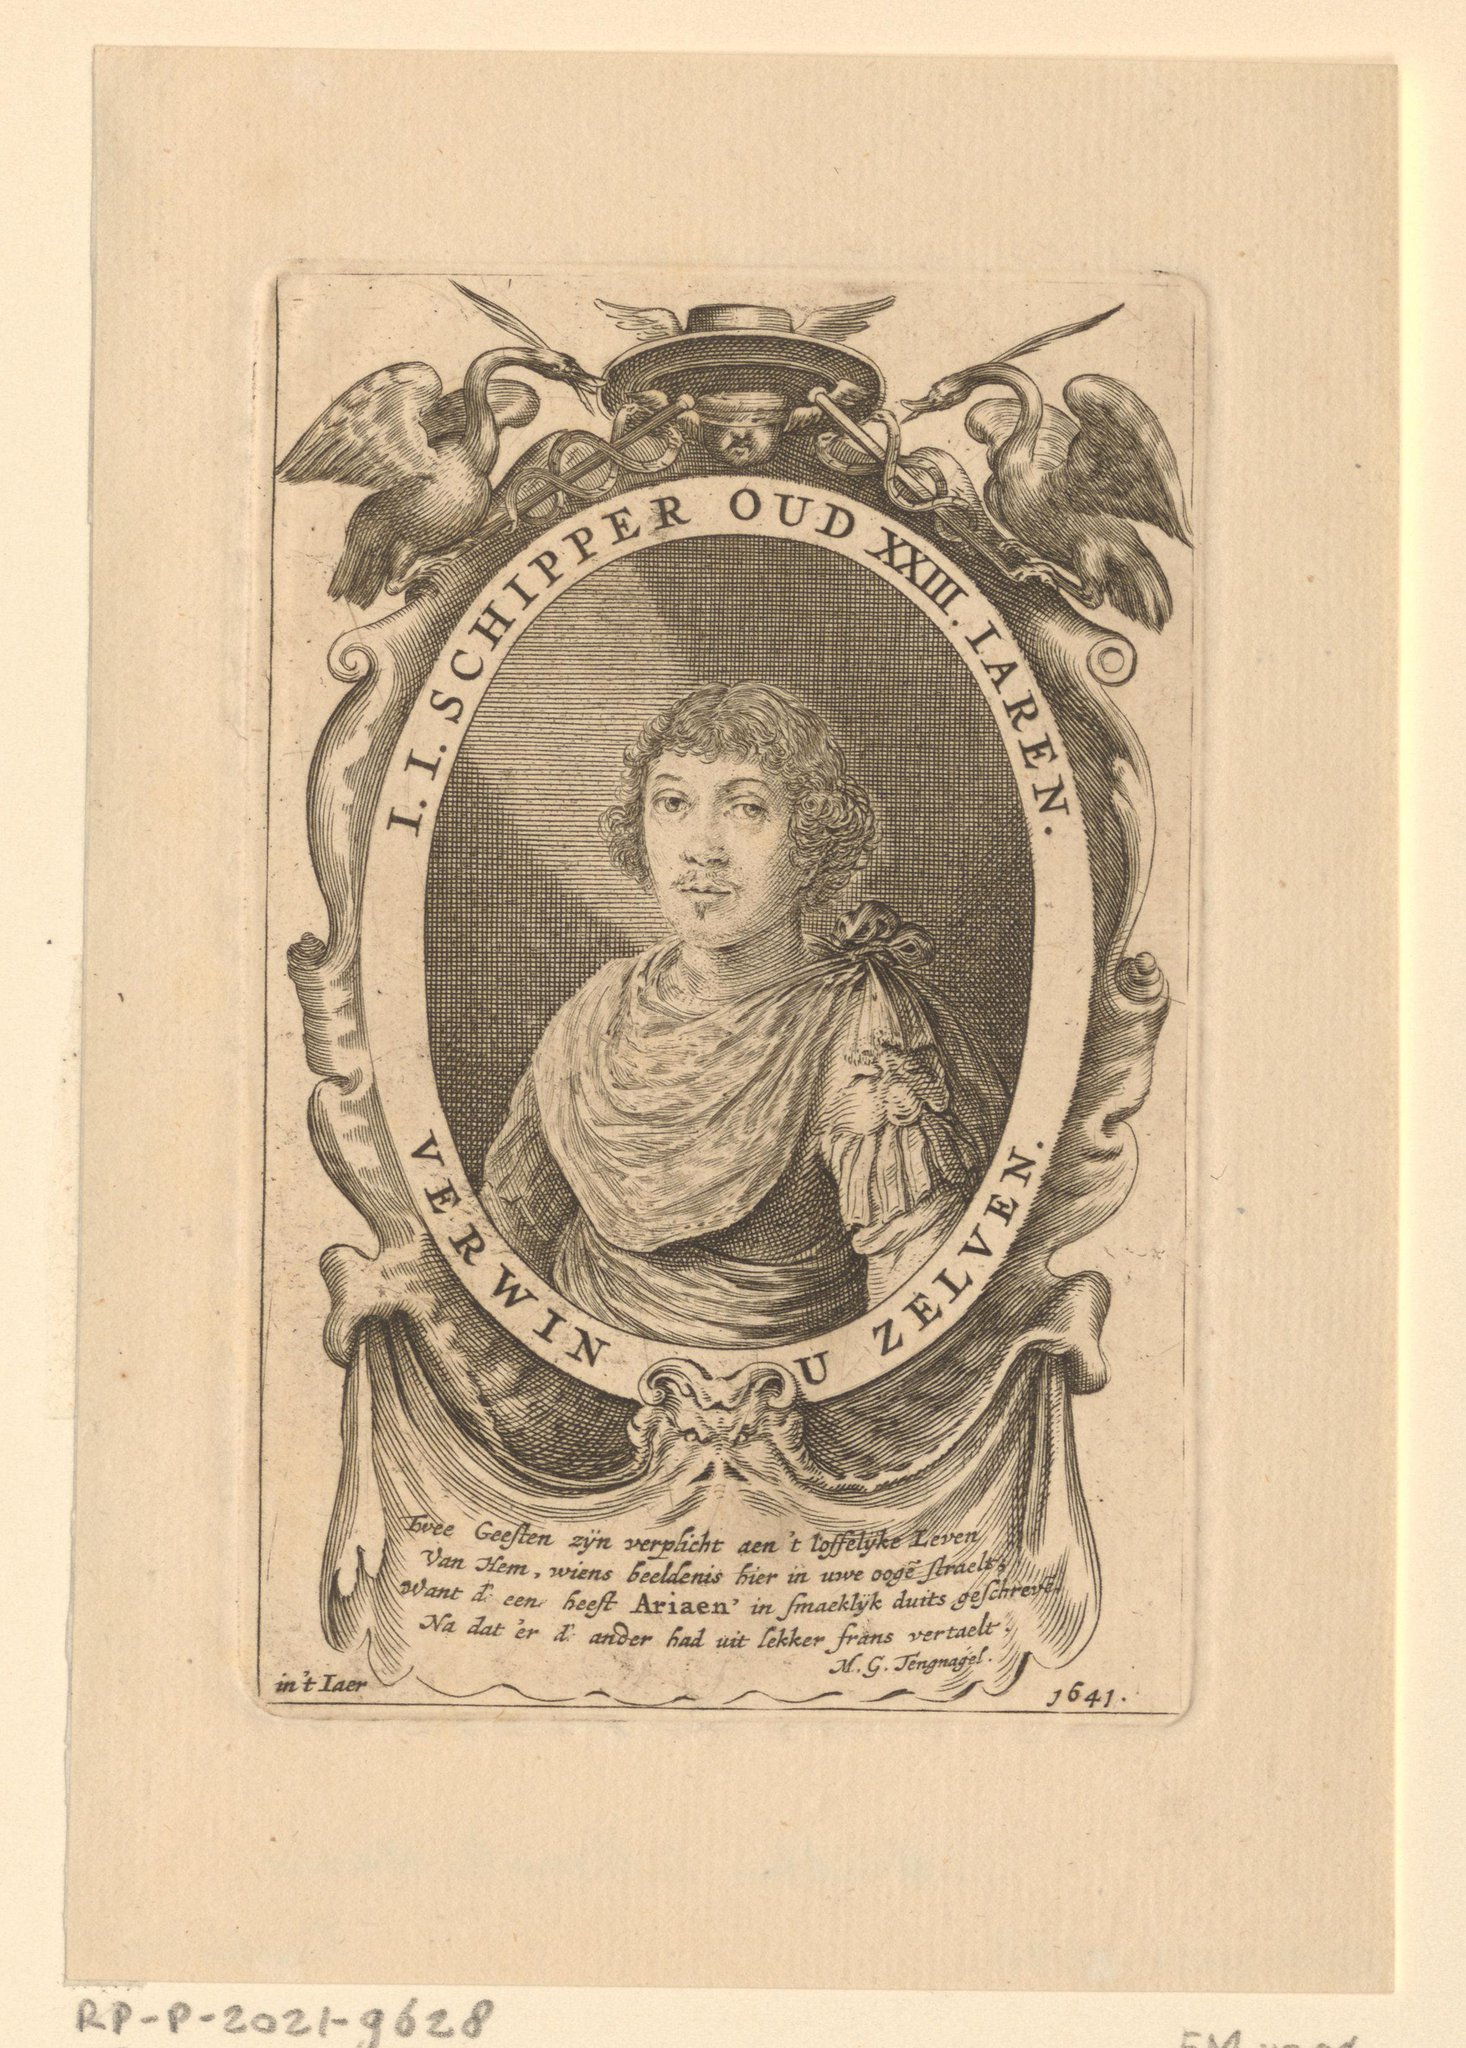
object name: print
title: Portret van Jan Jacobsz. Schipper op 23-jarige leeftijd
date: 1644-1646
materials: paper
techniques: engraving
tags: jan jacobsz. schipper, historical persons, publishing, publisher, writer, poet, author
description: Prent waarschijnlijk uit: Schippers, Jan Jacobsz. Ariane, treurspel. Amsterdam: Dirck Cornelisz Hout-naeck, 1644. Of uit: Schippers, Jan Jacobsz. D'onvergelijkelijke Ariane. Amsterdam: Jan Jacobsz. Schipper, 1646.